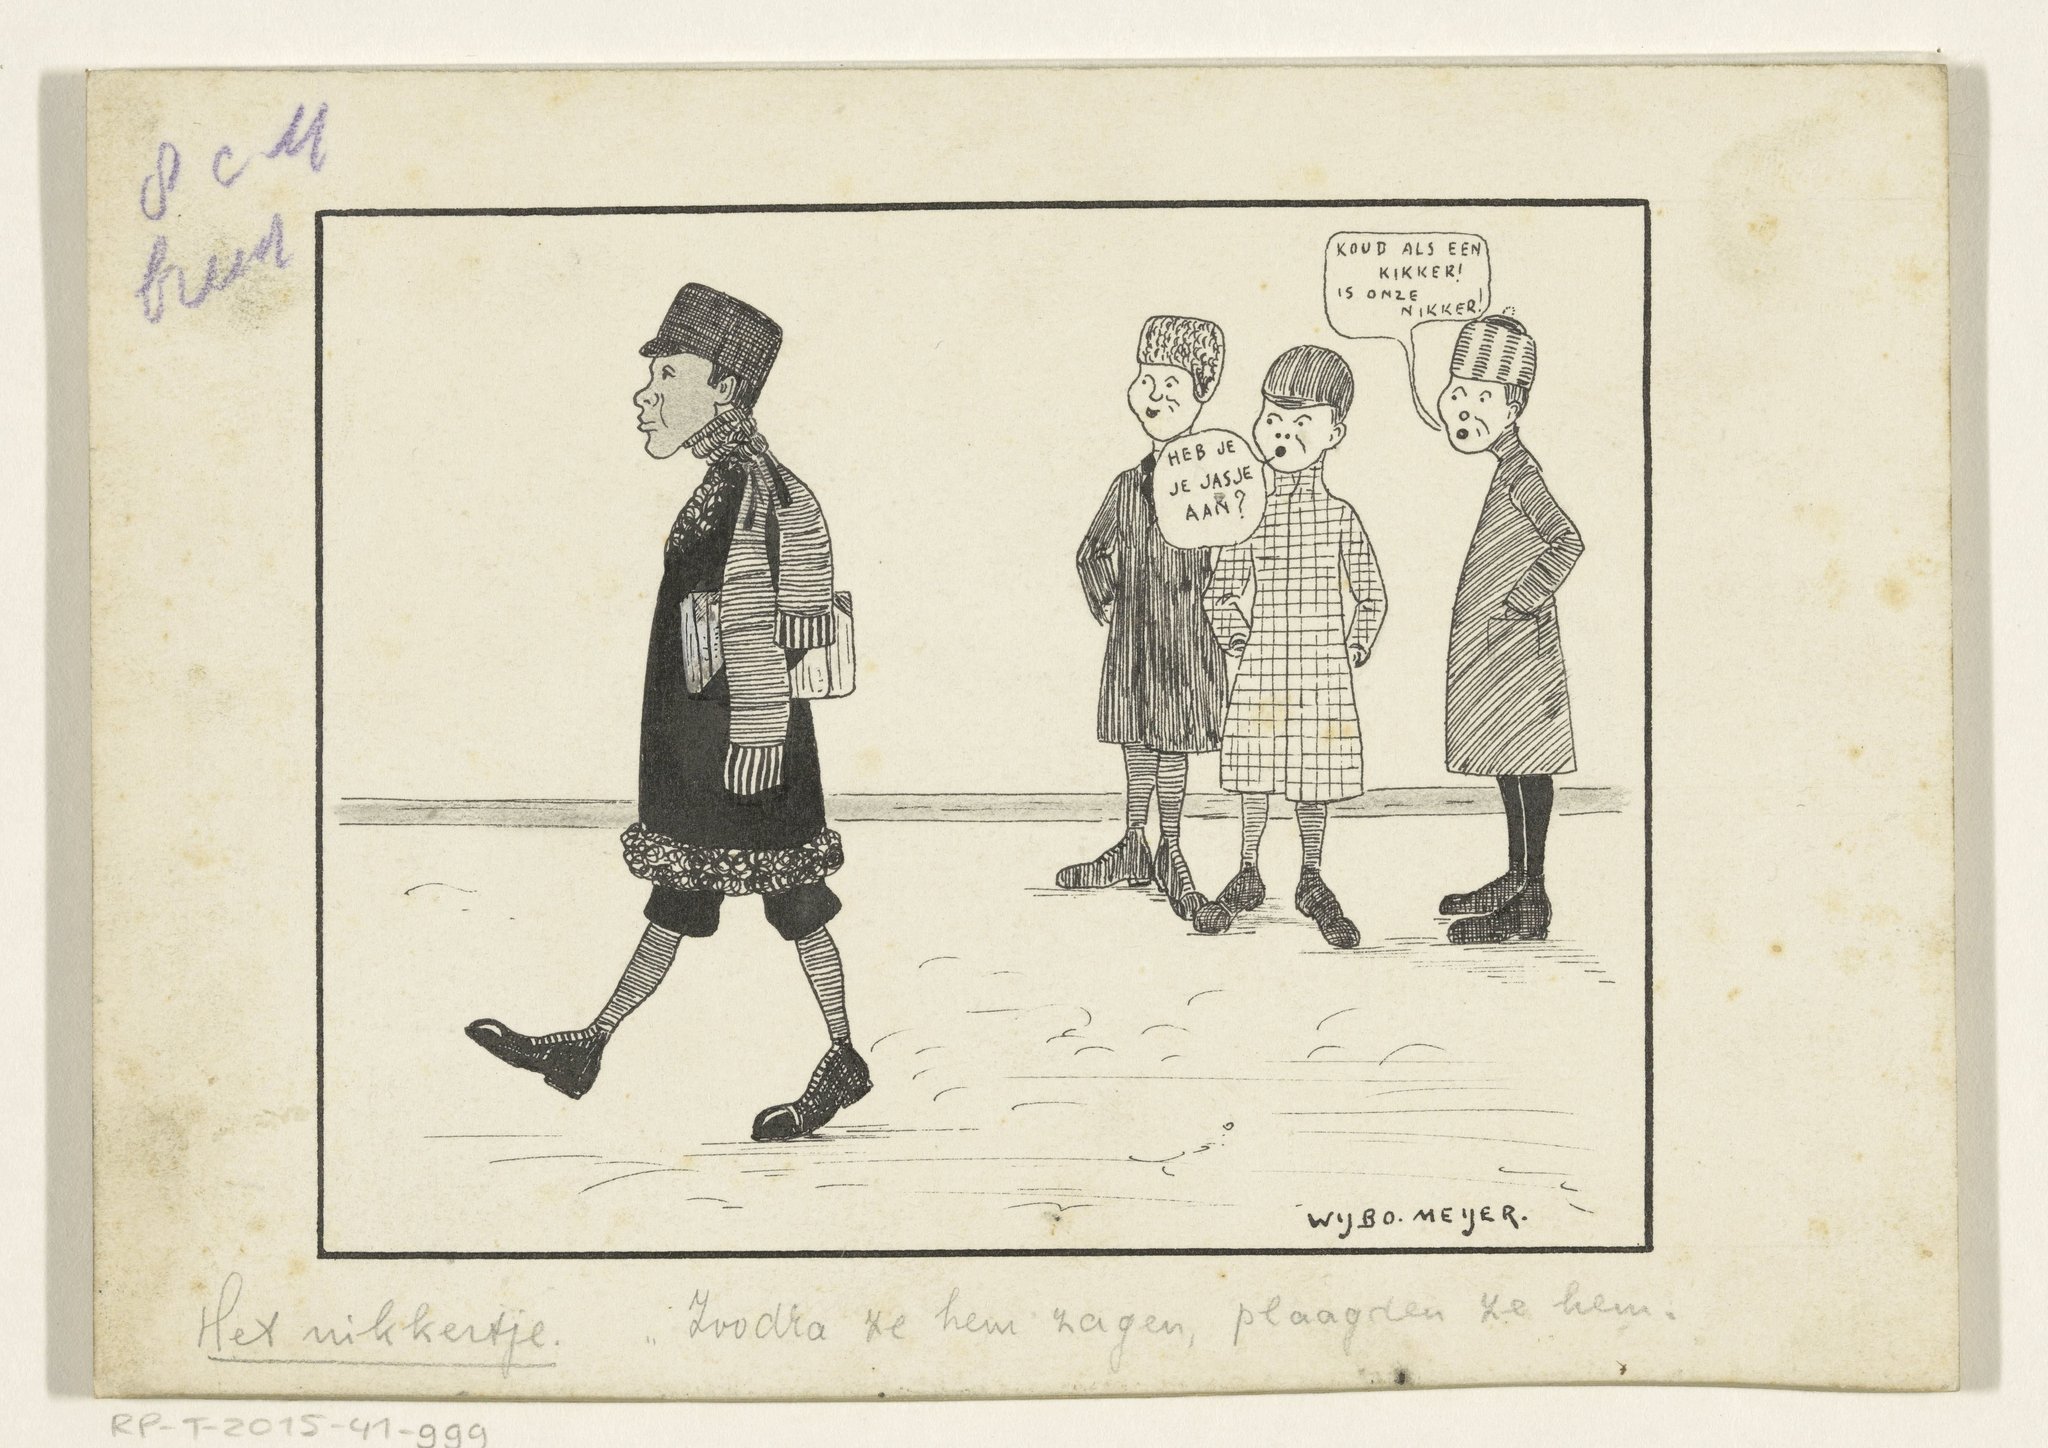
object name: boekillustratie ontwerp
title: Drie witte jongens pesten een zwarte jongen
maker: wybo meijer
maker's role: draughtsman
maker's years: 1885-1942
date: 1895-1942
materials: cardboard, paint, ink, watercolor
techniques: brush, pen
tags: boy (child between toddler and youth), mocking, insulting; teasing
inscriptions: signature: ‘WIJBO. MEIJER.’, annotation: ‘Het nikkertje. "Zoodra ze hem zagen, plaagden ze hem.’, :, collector's mark: Lugt 2228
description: Op een straat staan drie witte jongens in jassen en met mutsen op. Ze roepen beledigingen naar een zwarte jongen die passeert. De zwarte jongen draagt een winterjas, sjaal en muts en heeft een tas onder de arm geklemd.